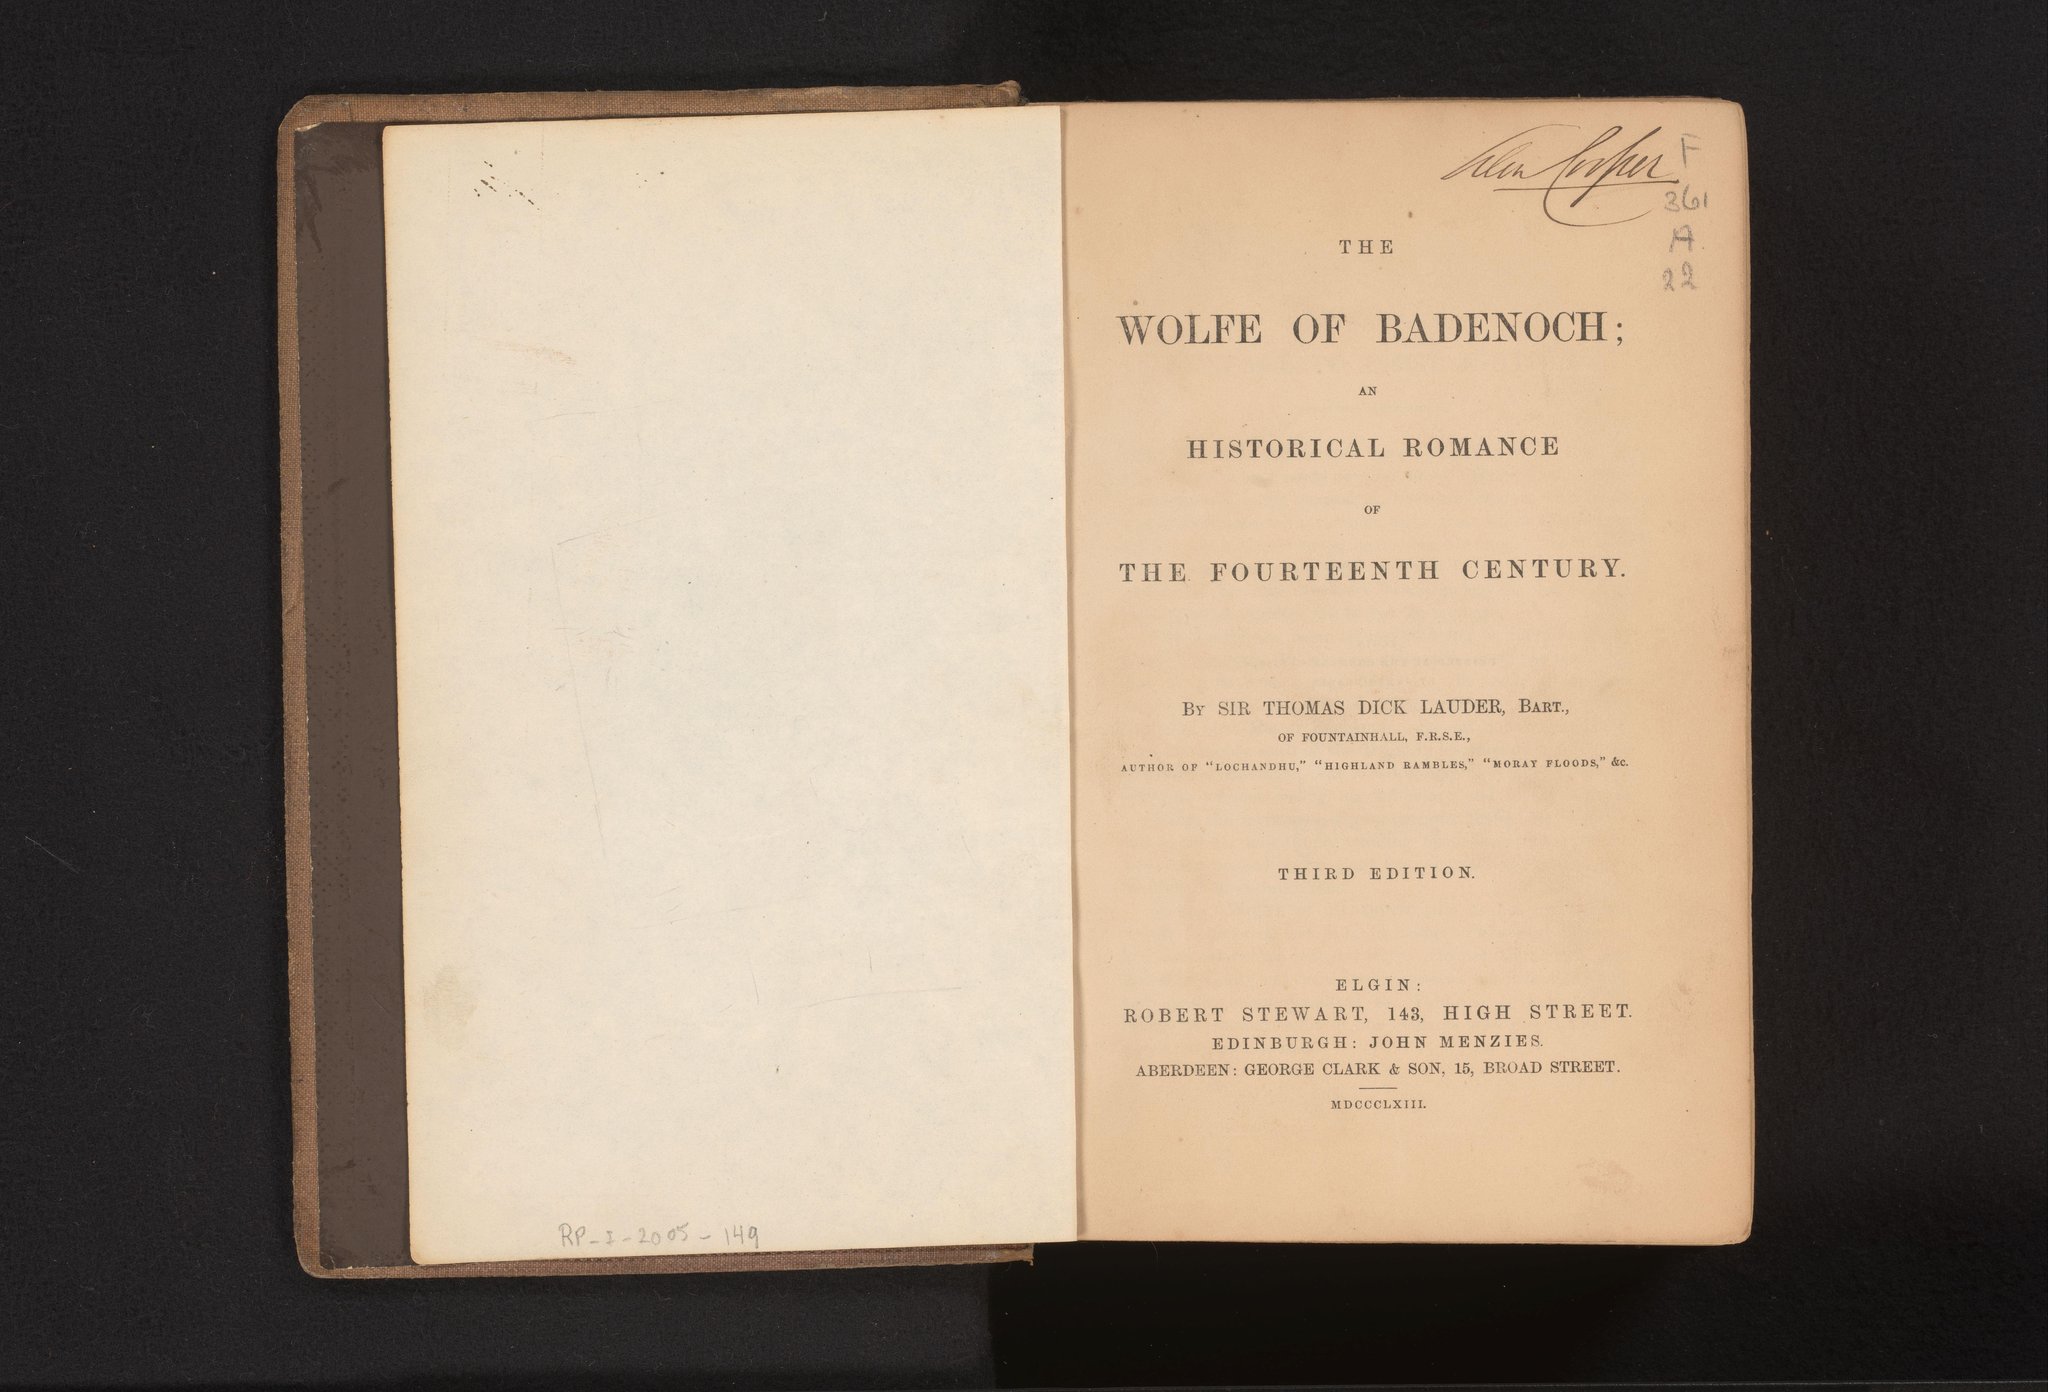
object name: book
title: The wolfe of Badenoch : an historical romance of the fourteenth century / by Thomas Dick Lauder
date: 1863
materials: cardboard, linen, paper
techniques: albumen print, printing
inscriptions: annotation: ‘MAY/ 2005’